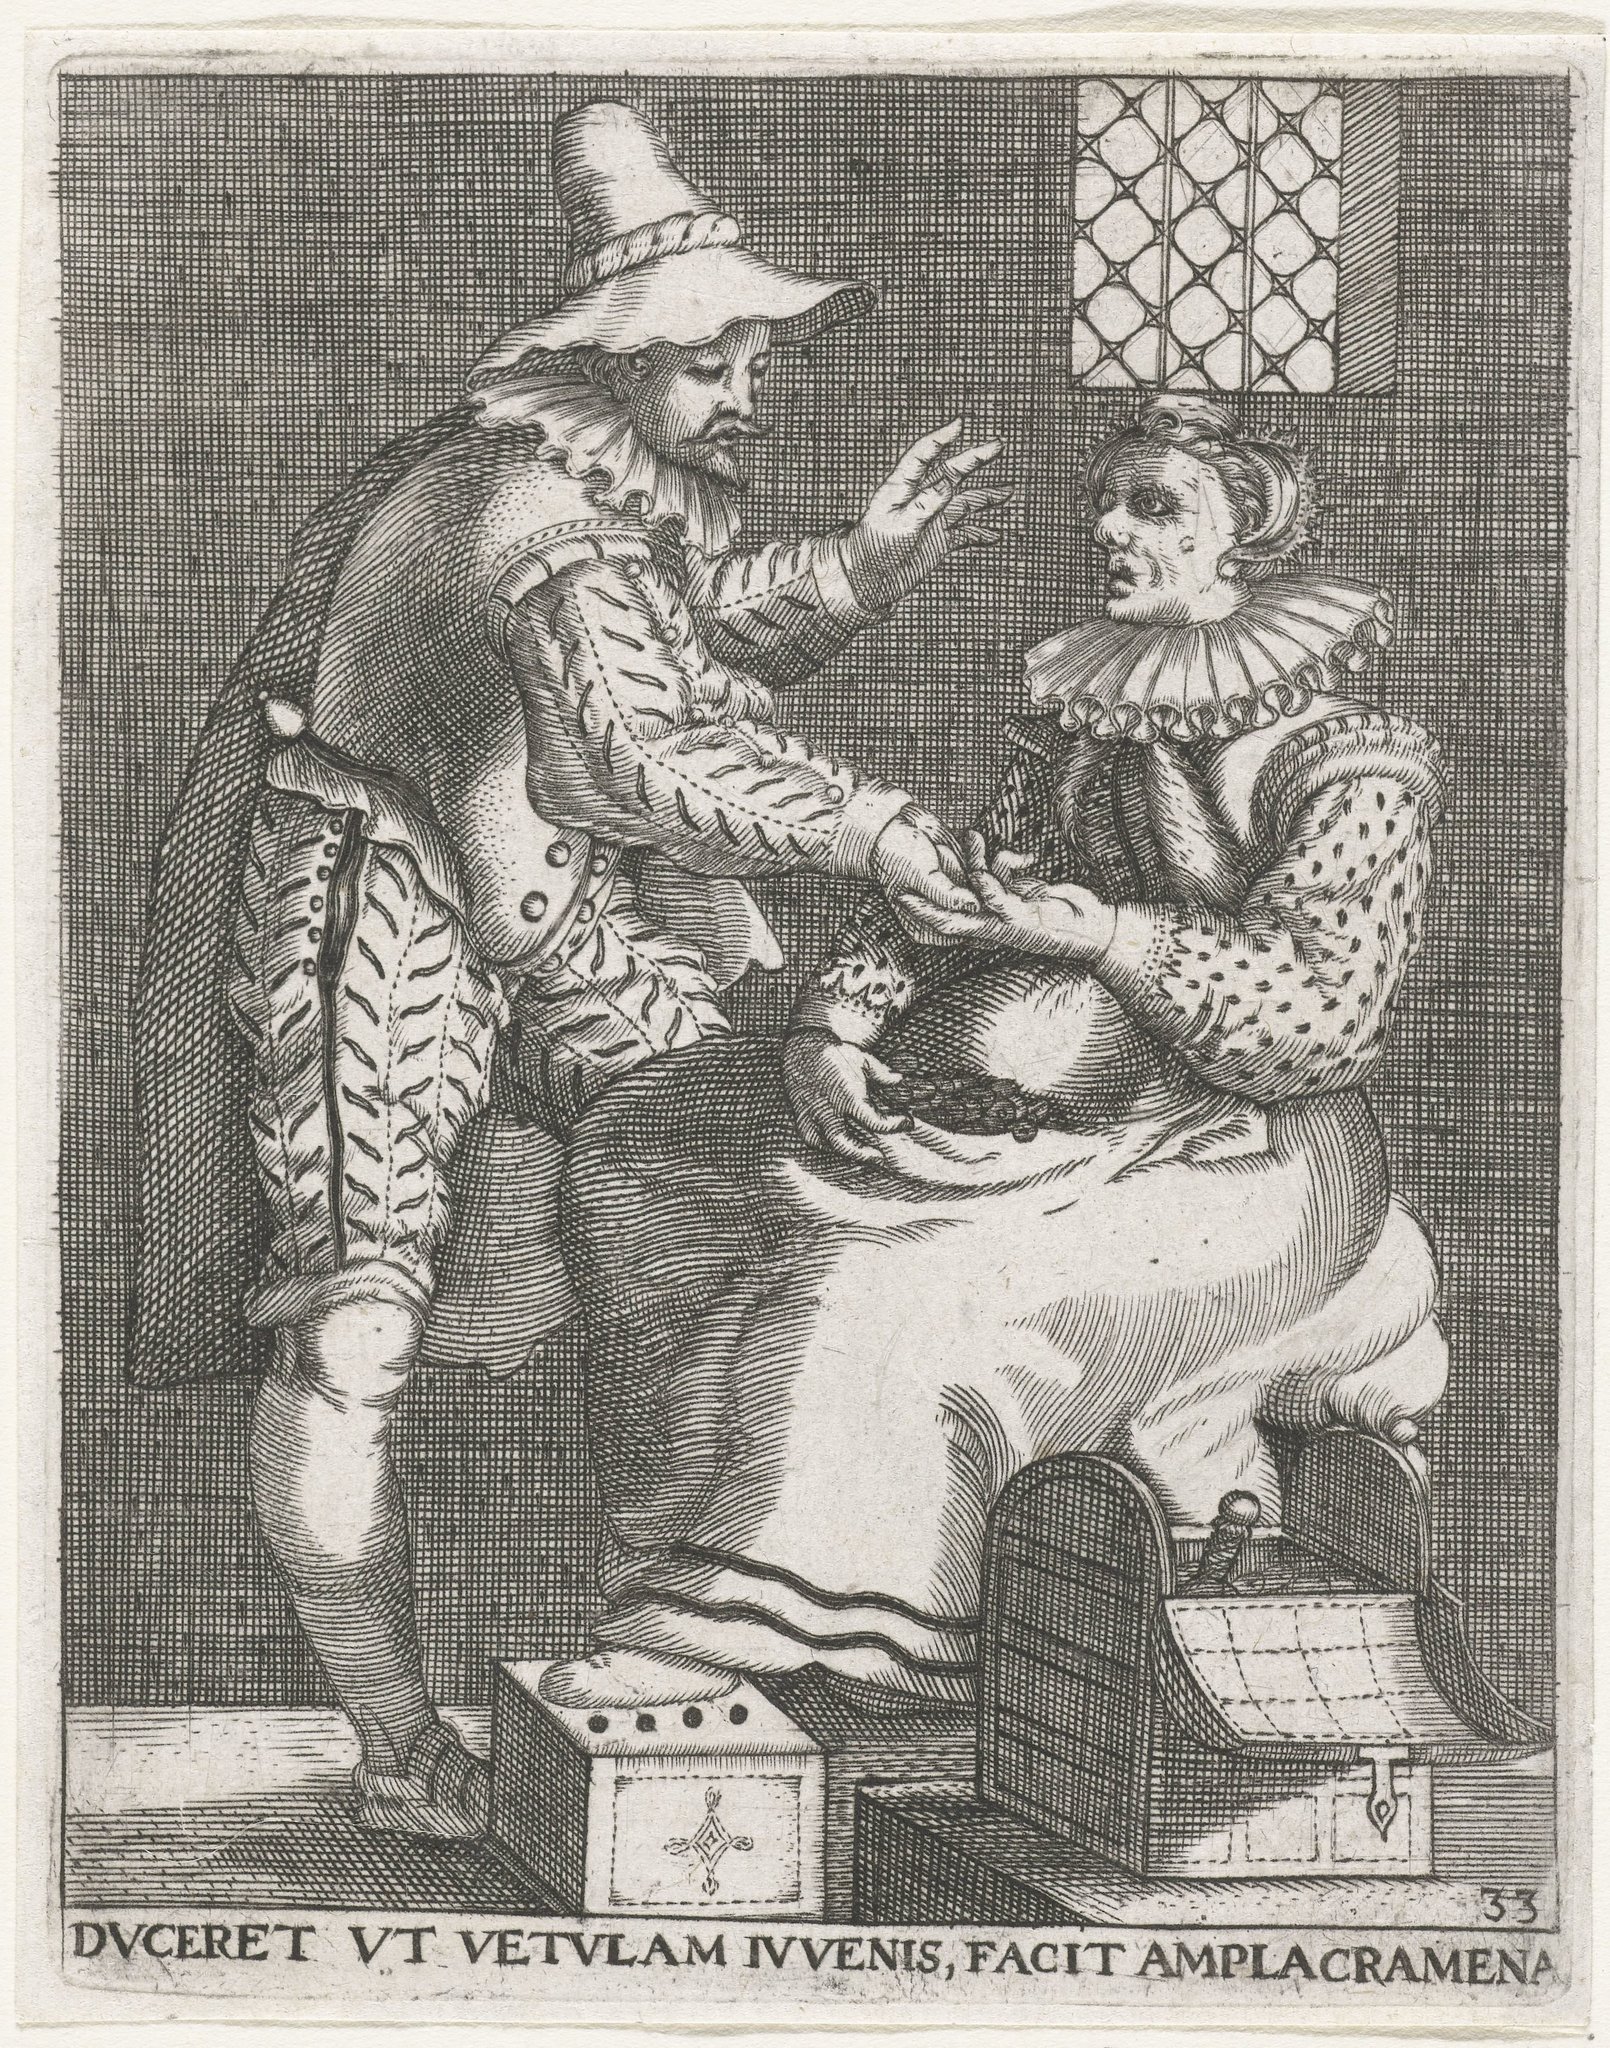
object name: cognizance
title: Emblemata Saecularia, 1596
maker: johann theodor de bry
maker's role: print maker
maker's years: 1561-1623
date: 1596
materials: paper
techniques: engraving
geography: frankfurt am main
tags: existence and modes of existence (+ emblematical representation of concept), married couple of unequal age - dd - woman older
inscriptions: number: ‘33’, inscription: ‘DUCERET UT VETULAM IUVENIS, FACIT AMPLACRAMENA’, collector's mark: Lugt 240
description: Bijbehorende tekst van epigram in album: : D'oude berimpeld'om t' ghelt sal ick trawen/Soo vind ick in cooyen/wel ander vroowen. Furwar dis alte reissel eisen/ Thut mir vil roter gulden weisen/ Ich traw sie mir, han ich gelt/ Iung frawlewt krieg wie mirs gefelt. Afkomstig uit: Emblemata Saecularia. Mira et iucunda varietate seculi huius mores ita experimentia (...). 1e druk. Frankfurt am Main: J.T. de Bry en J.I. de Bry, 1596.